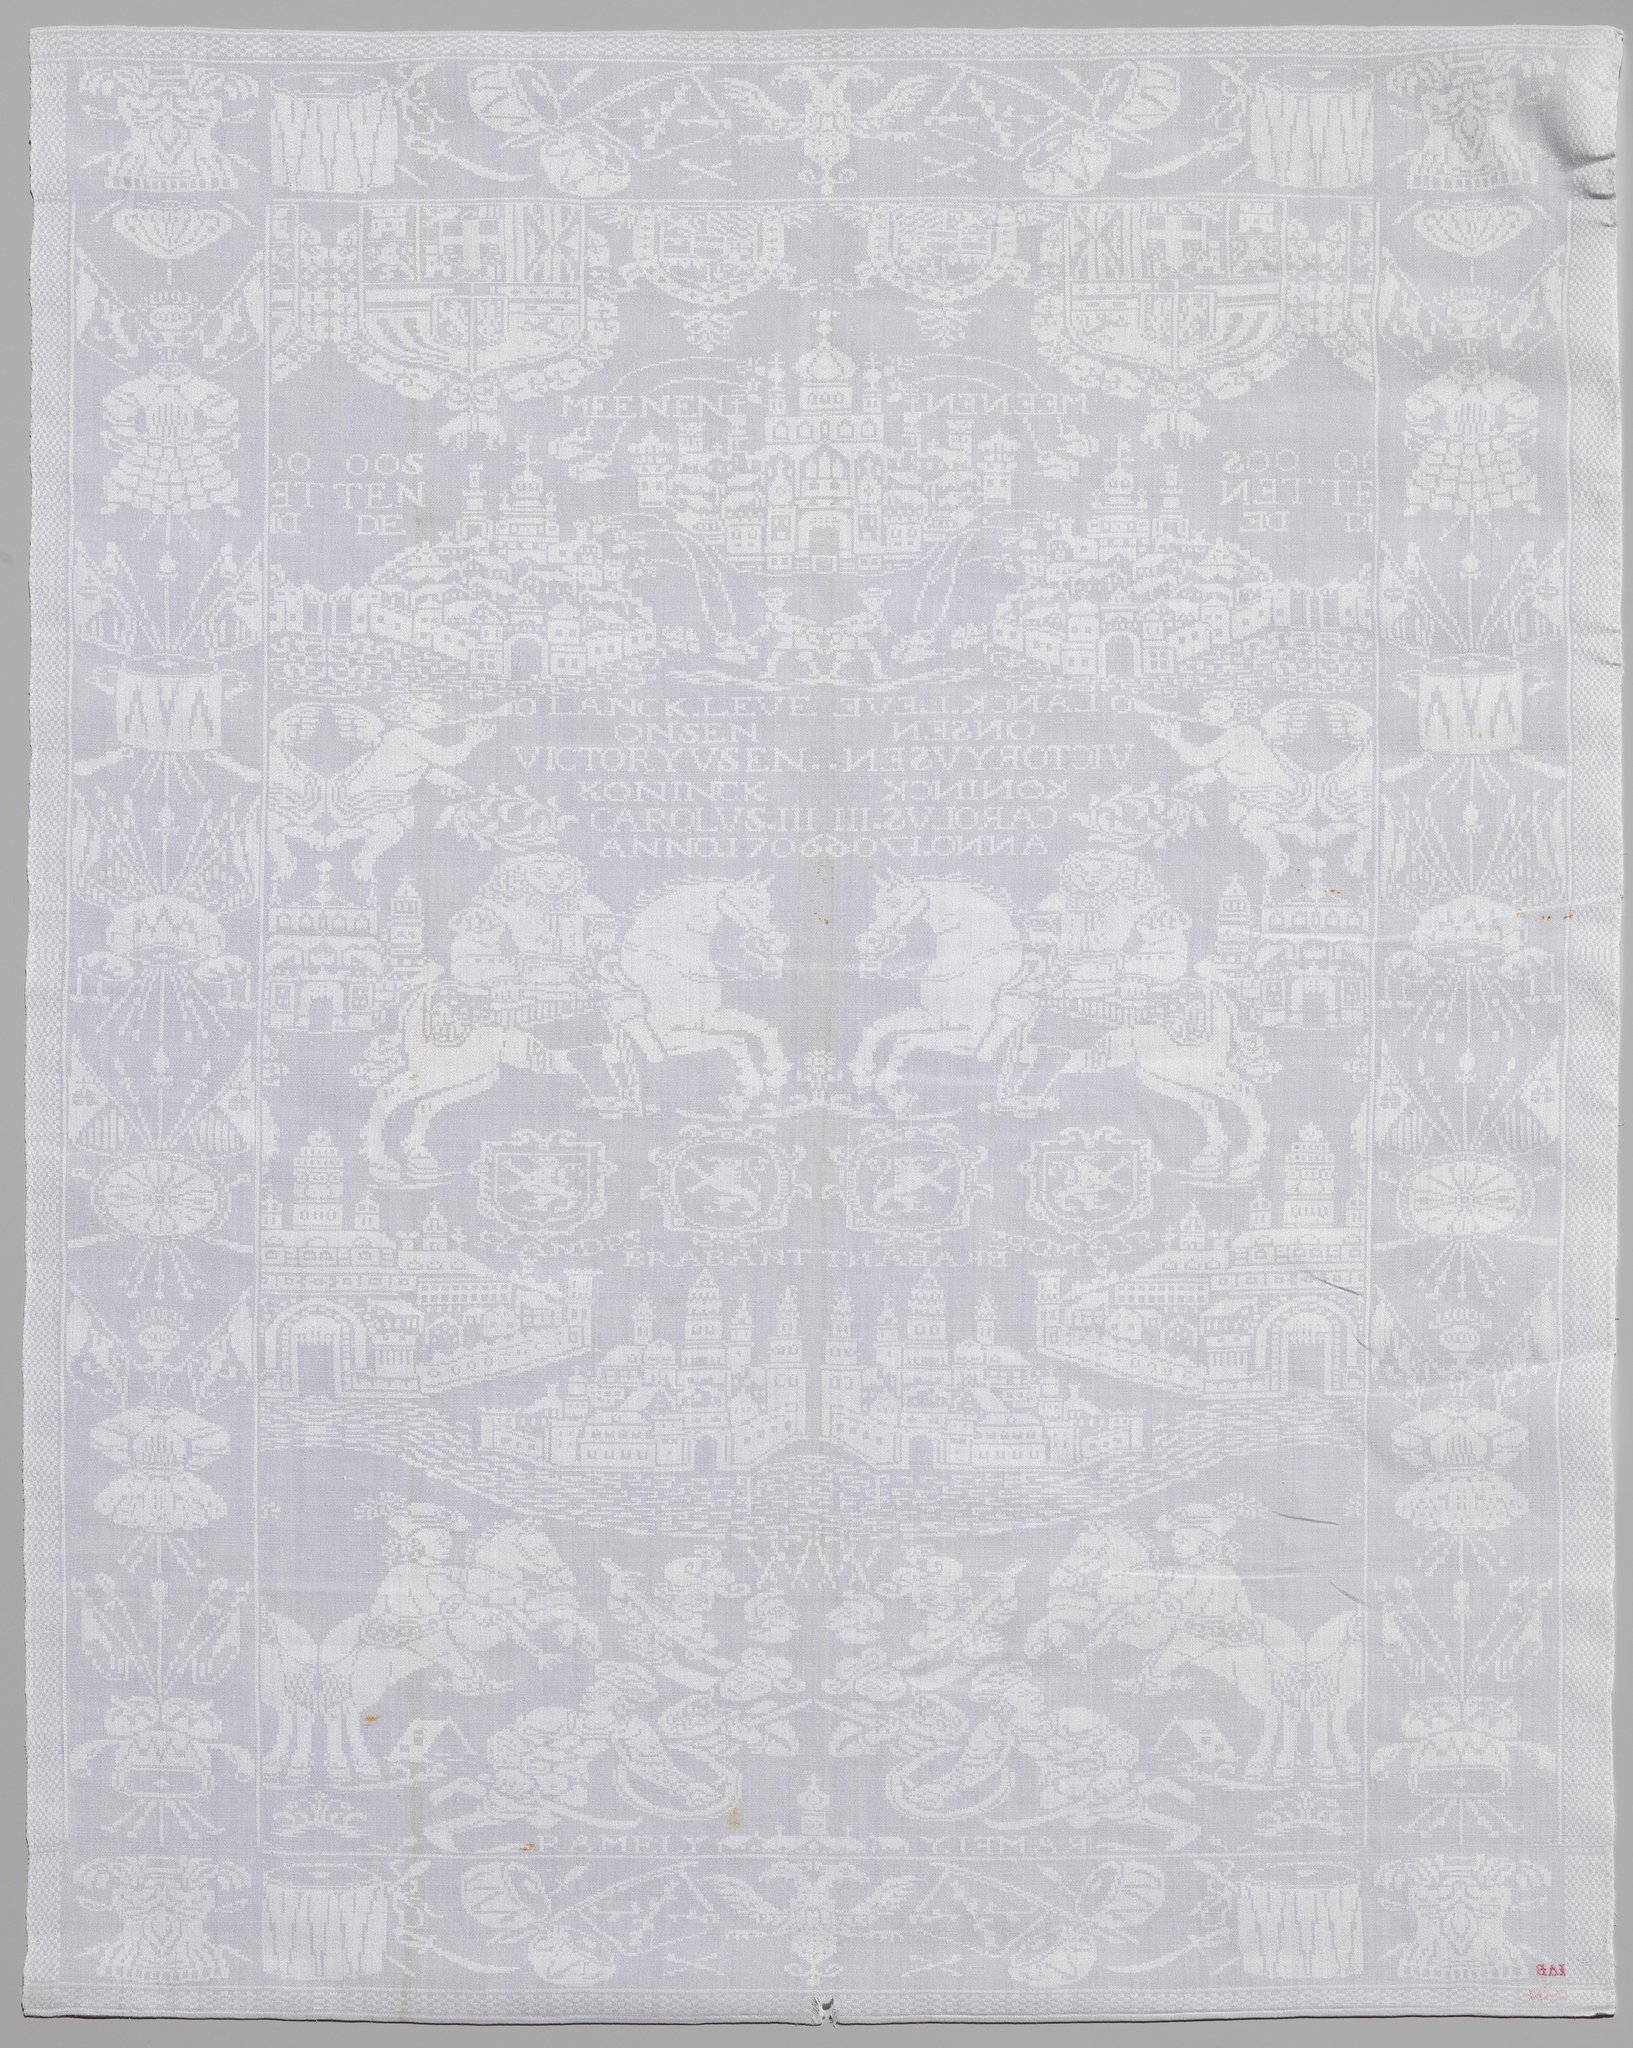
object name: napkin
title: Servet van linnendamast met een historisch tafereel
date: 1706-1725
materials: linen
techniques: damask, weave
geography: flanders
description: Servet van linnendamast met de verheerlijking van Karel III als koning van Spanje na de slag bij Ramilies.